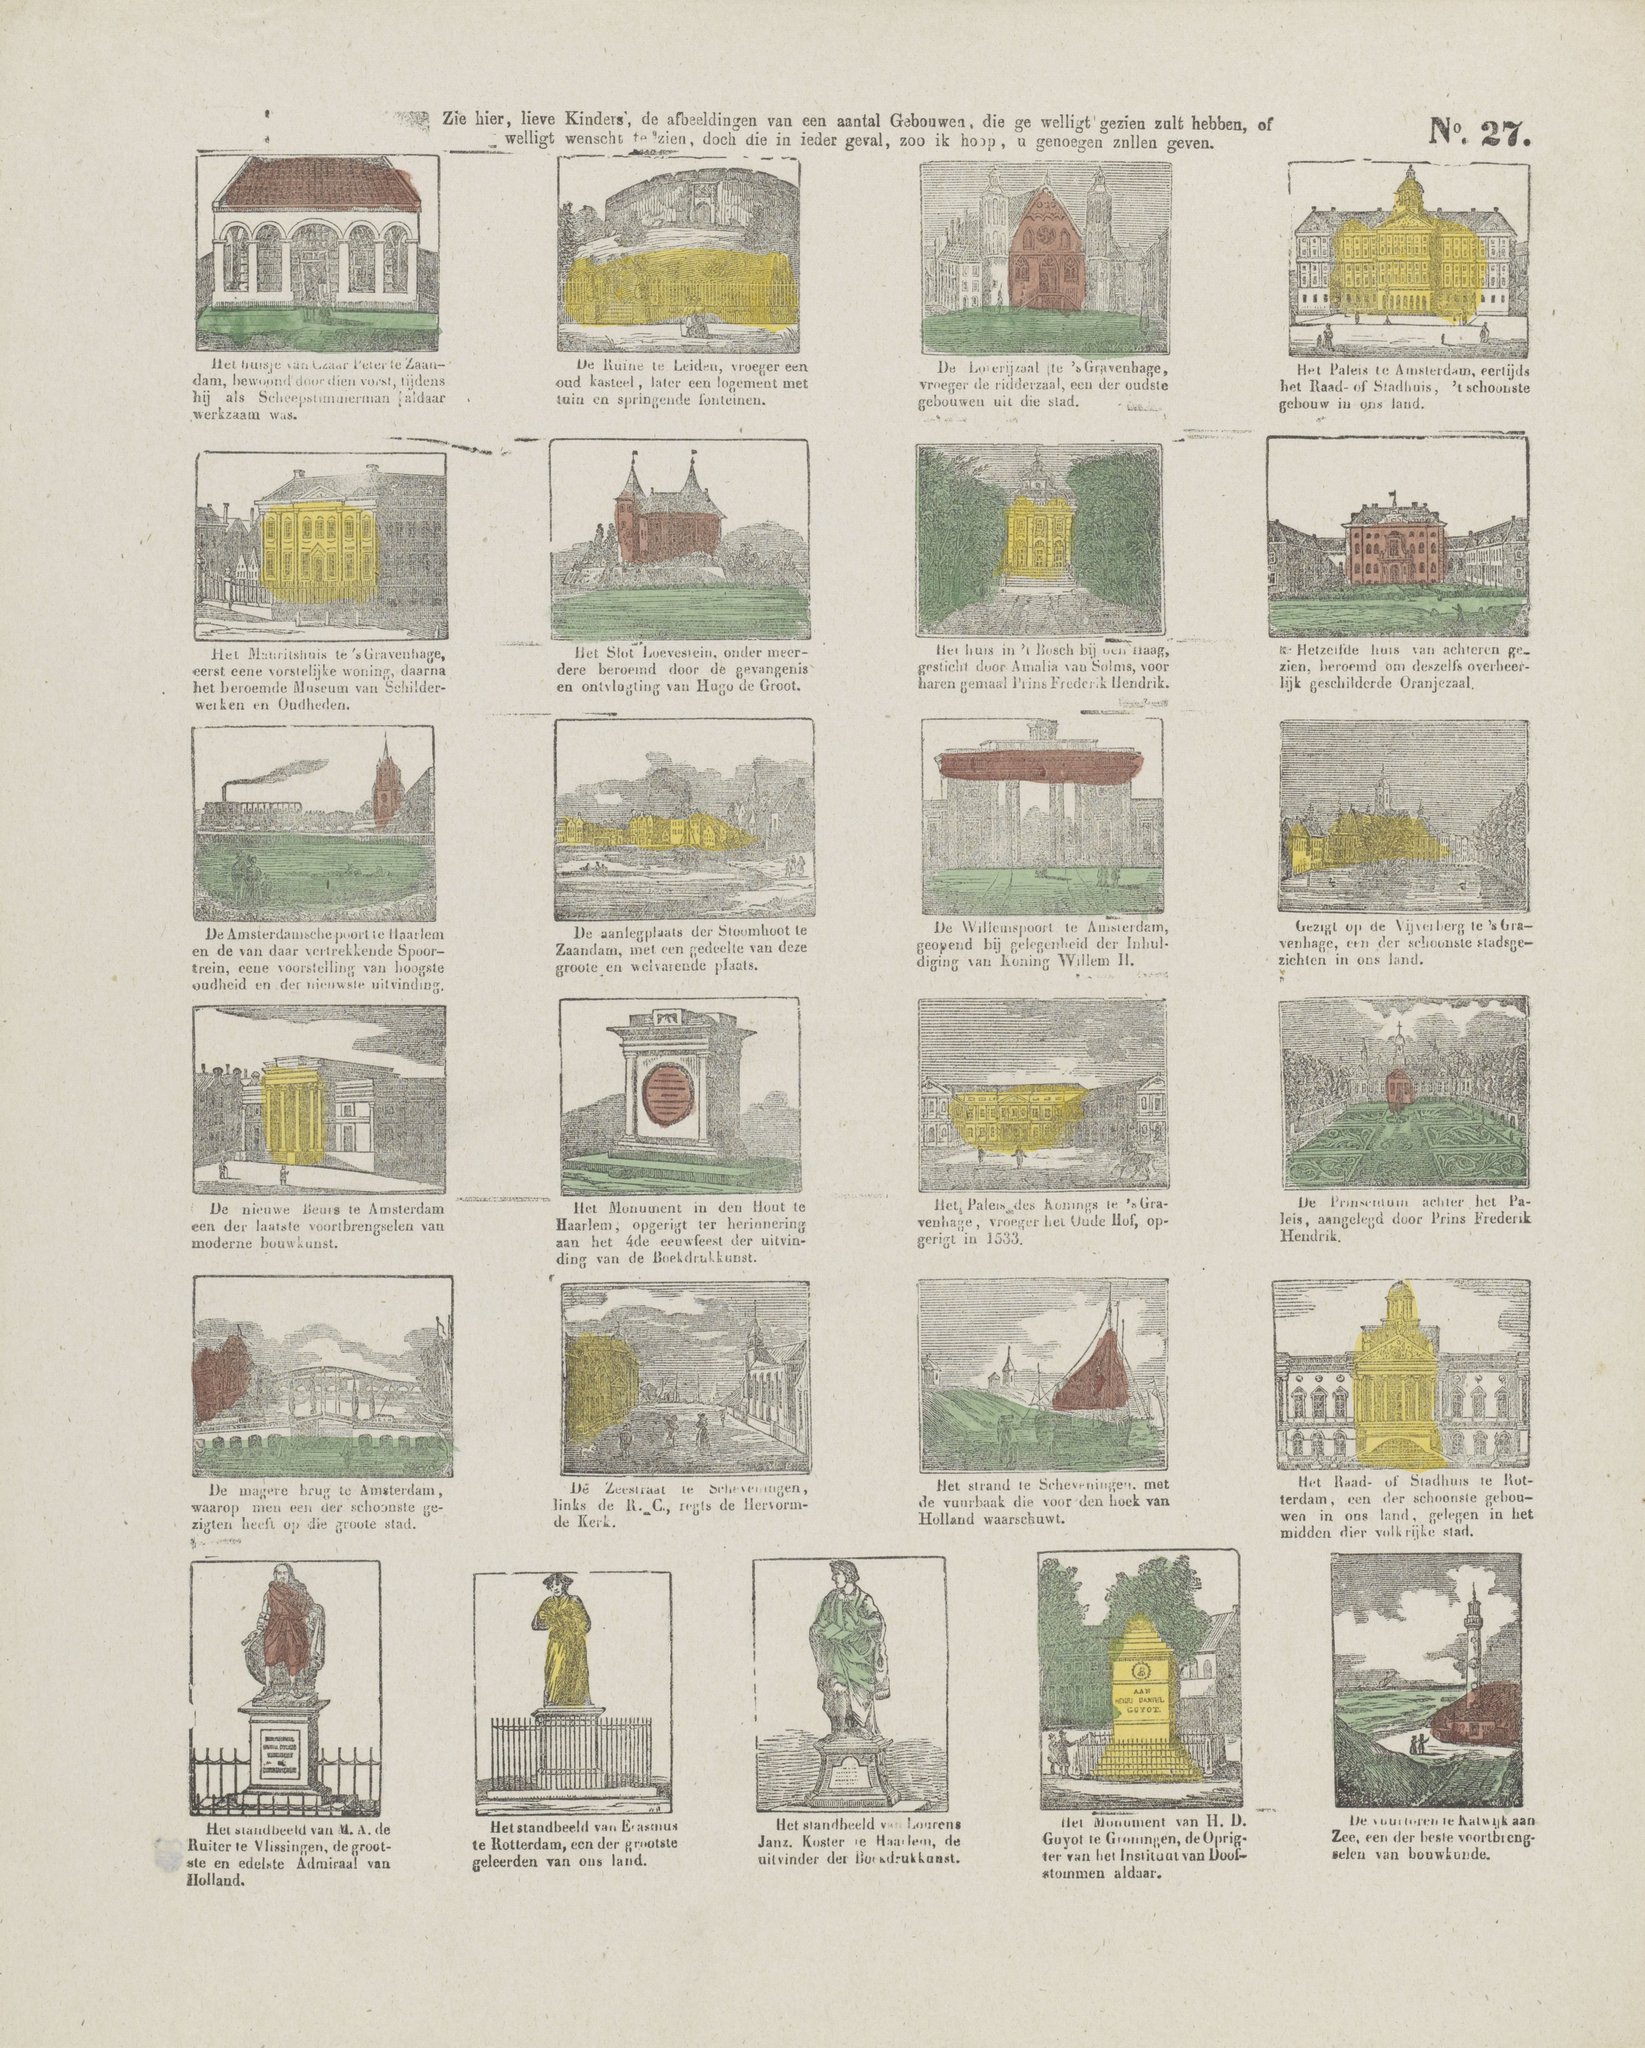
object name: print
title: Zie hier, lieve Kinders, de afbeeldingen van een aantal gebouwen, die ge welligt gezien zult hebben, of / welligt wenscht te zien, doch die in ieder geval, zoo ik hoop, u genoegen zullen geven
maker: willem bal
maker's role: print maker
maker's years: 1808-1897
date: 1850-1870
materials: paper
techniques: colour, letterpress printing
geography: netherlands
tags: rotterdam, desiderius erasmus, flushing, michiel adriaenszoon de ruyter, haarlem, palace, monument, statue, permanent exhibition, museum, the hague, loevestein castle, royal palace of amsterdam, amsterdam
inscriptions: collector's mark: Lugt 2760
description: Blad met 25 voorstellingen van gebouwen en monumenten in Nederland. Onder elke afbeelding een vierregelig vers. Rechtsboven genummerd: No. 27.